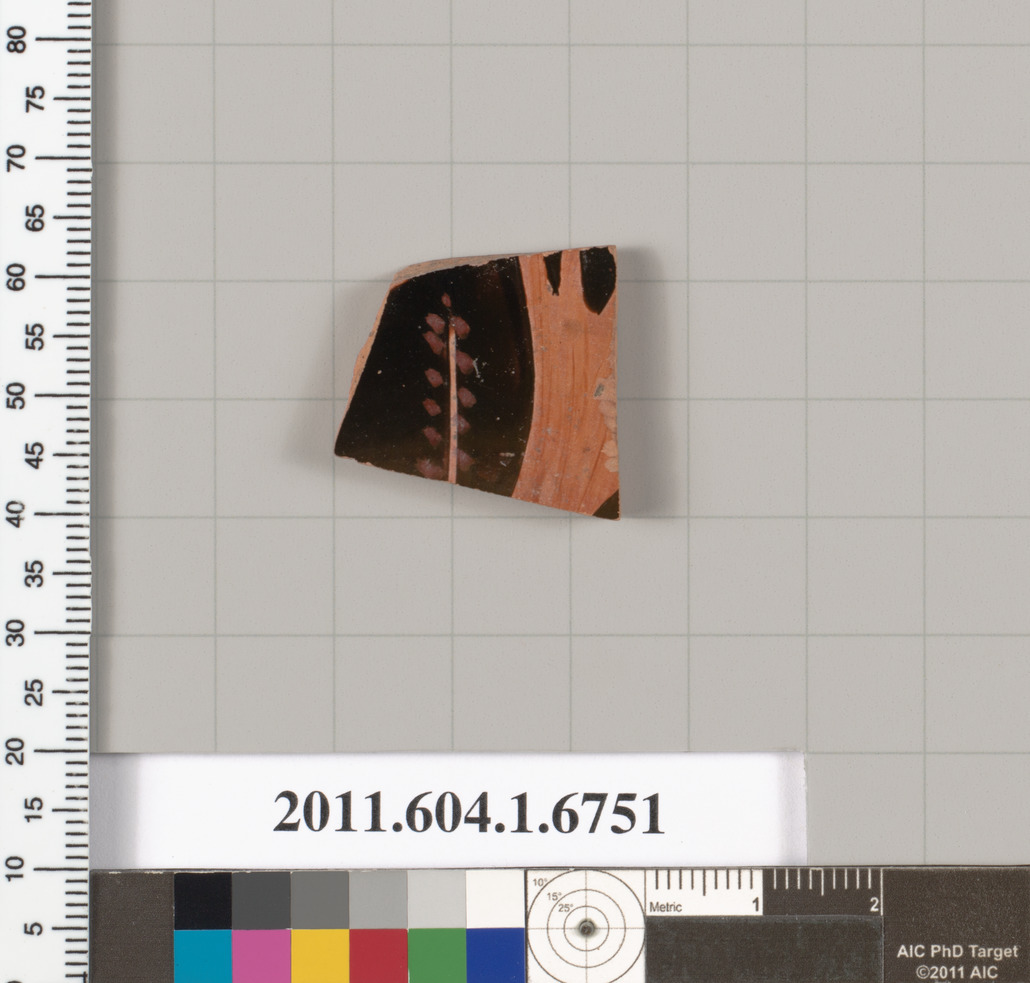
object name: kylix fragment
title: Terracotta fragment of a kylix (drinking cup)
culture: greek, attic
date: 490-470 BCE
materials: terracotta